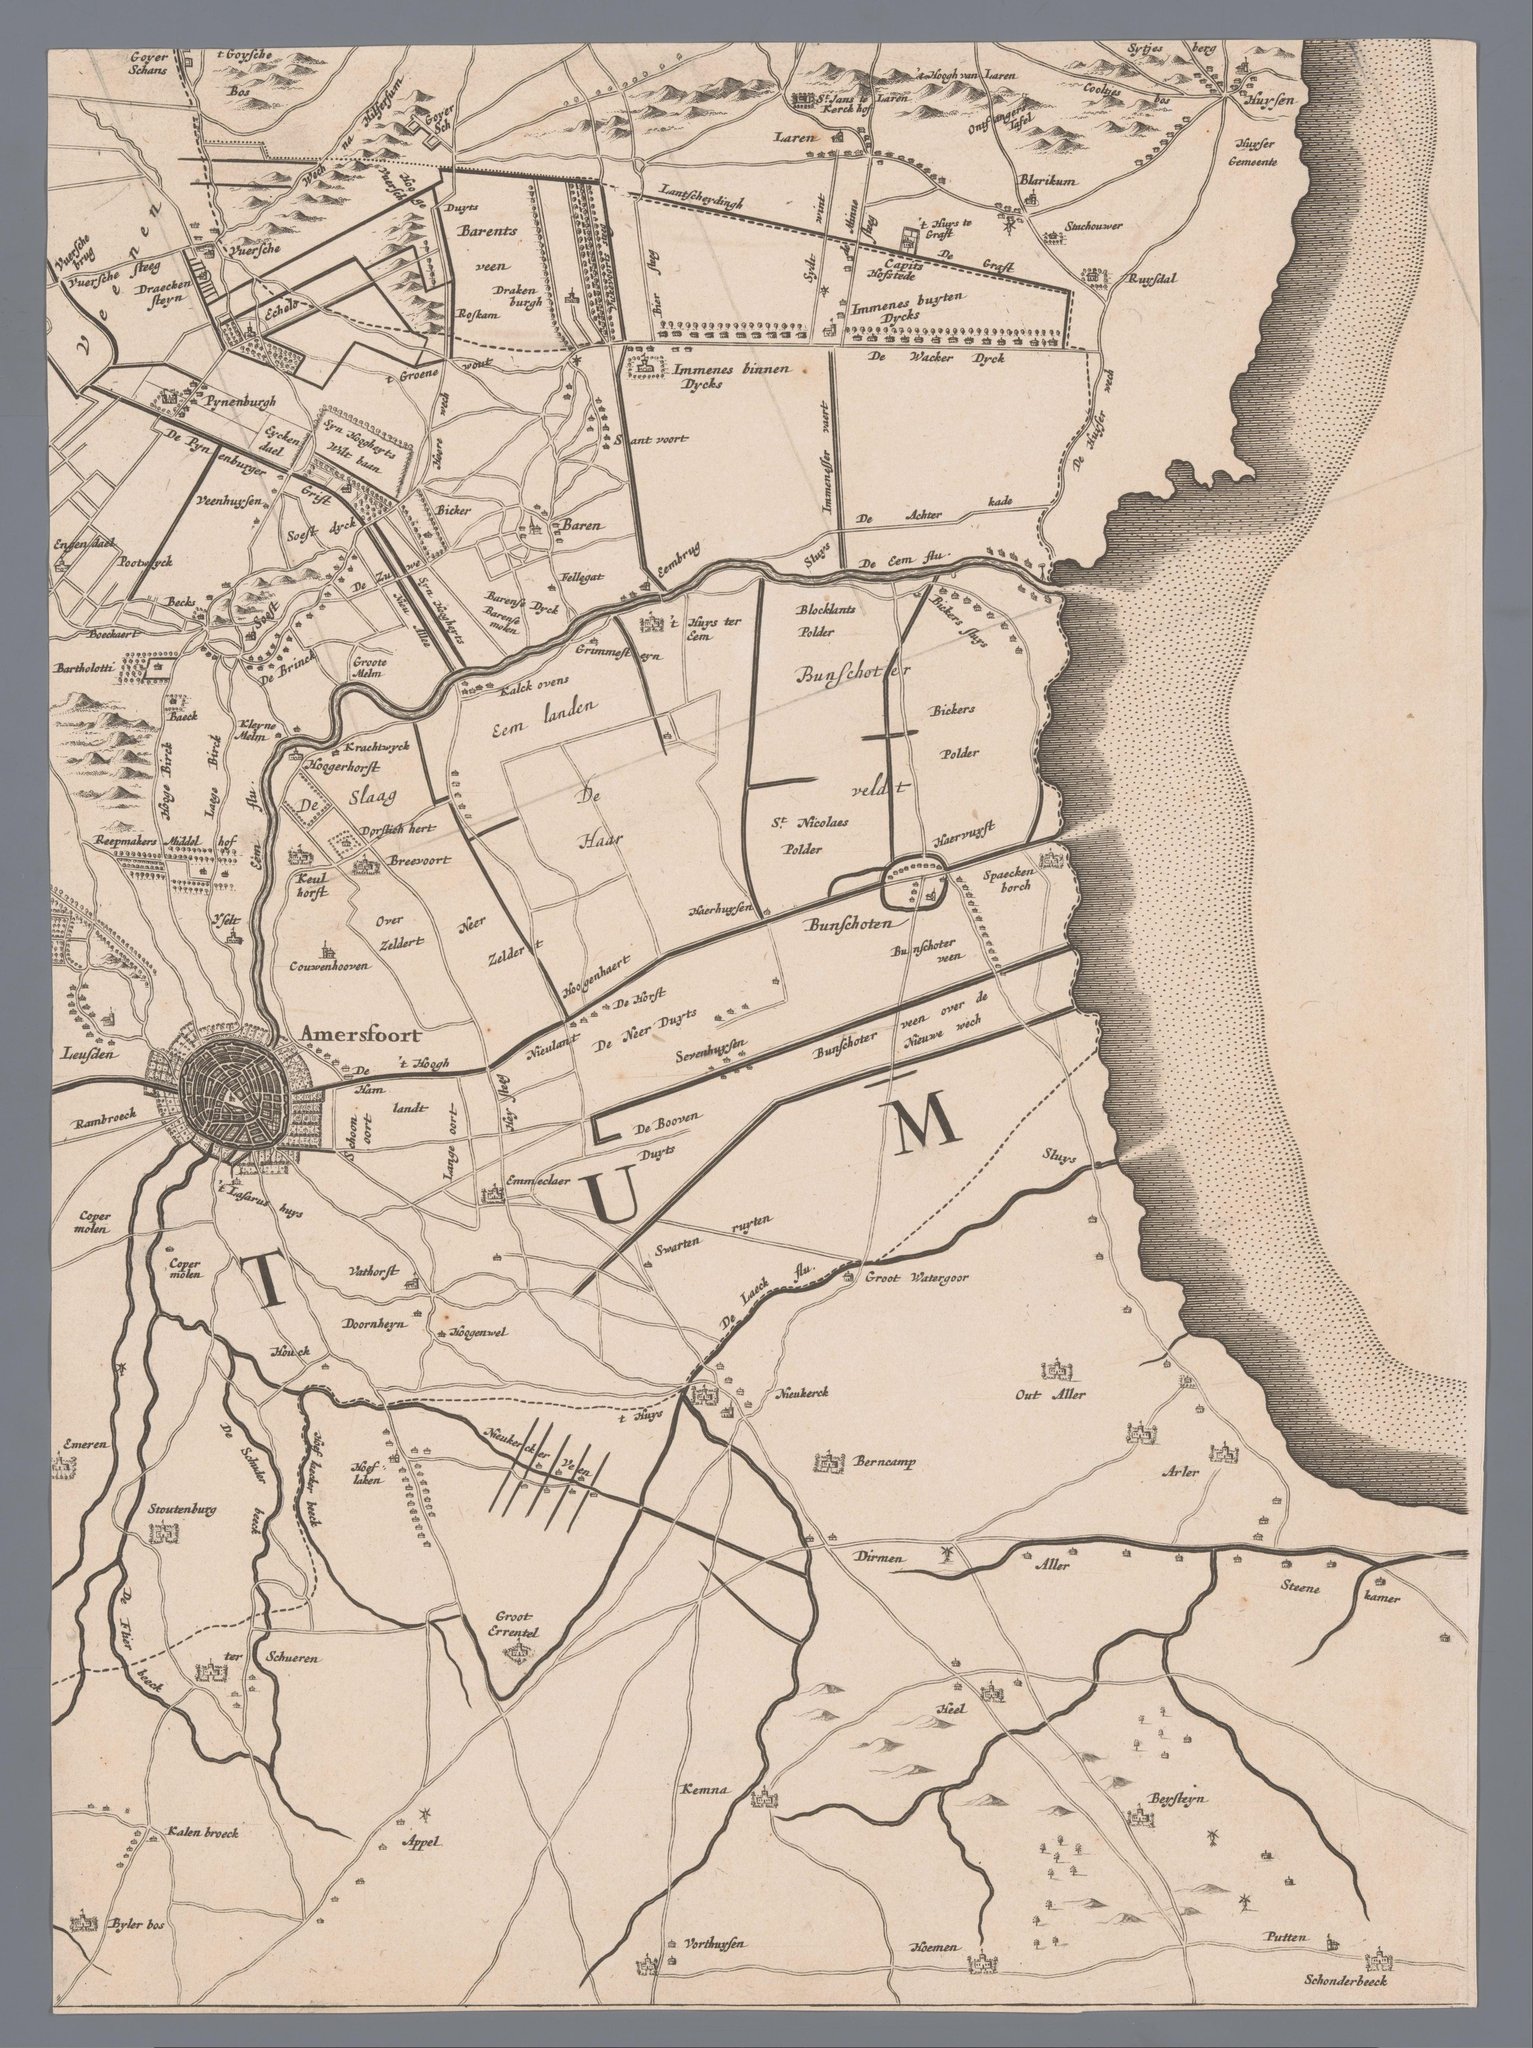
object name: map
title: Kaart van het Graafschap Holland en Utrecht (plaat 35)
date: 1639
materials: paper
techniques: engraving, etching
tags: maps, atlases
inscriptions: collector's mark: Lugt 2228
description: Onderdeel van een kaart samengesteld uit 40 bladen. Waarschijnlijk gaat het om de grootste kaart van Holland uit de zeventiende-eeuw. De kaart is uitgegeven in verschillende edities, deze kaart uit 1639 is de eerste editie.